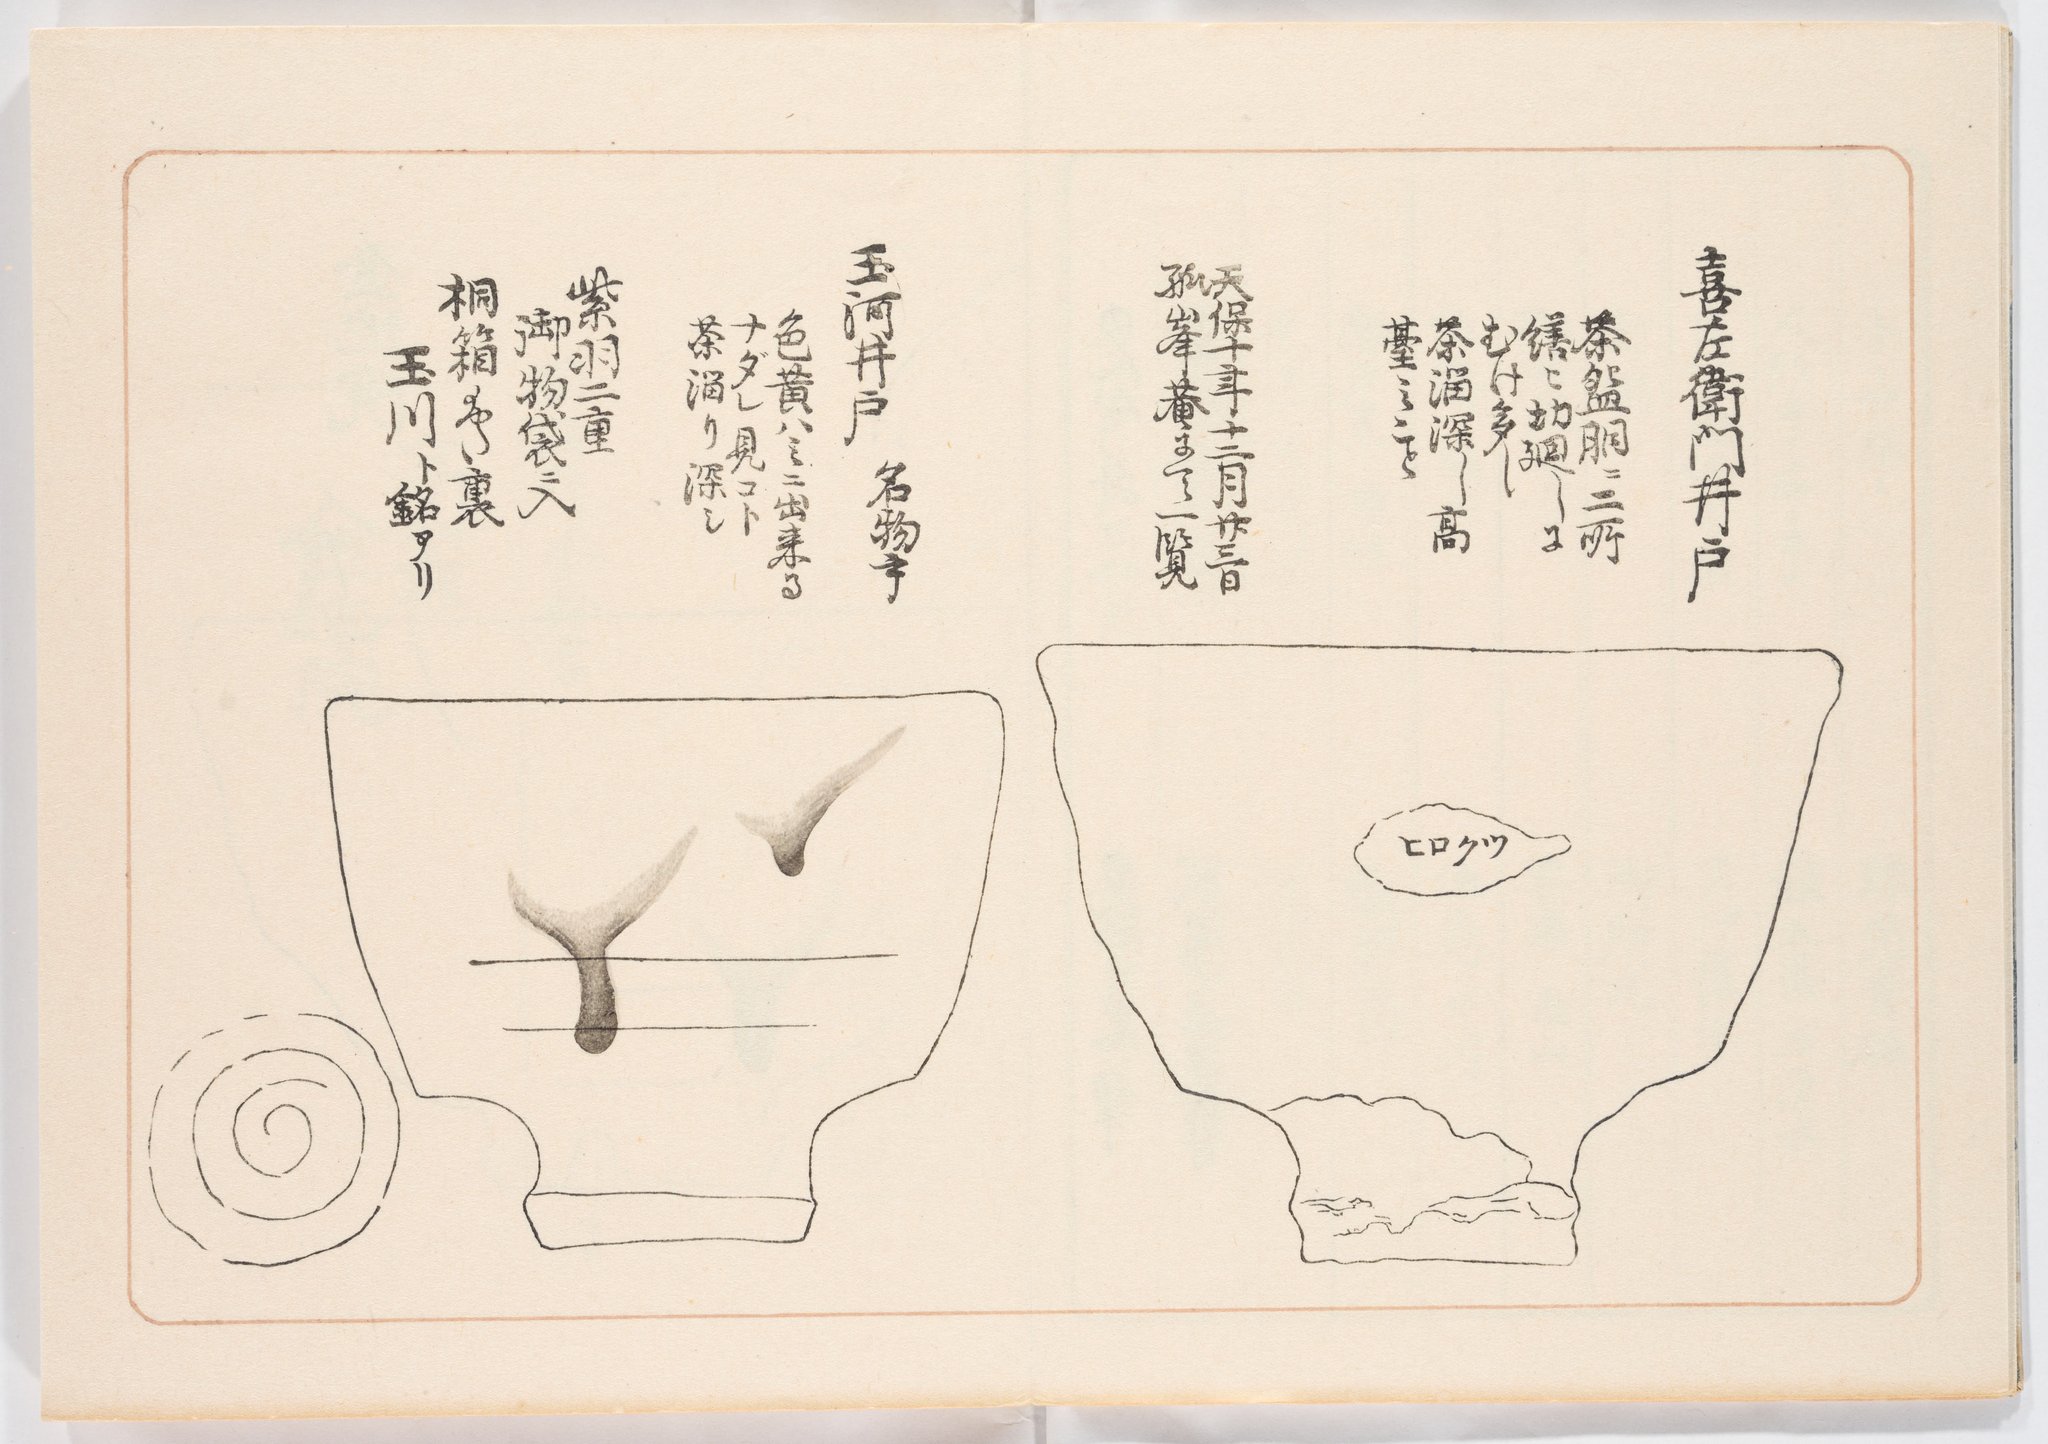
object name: illustrated book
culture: japanese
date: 1893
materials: ink, paper